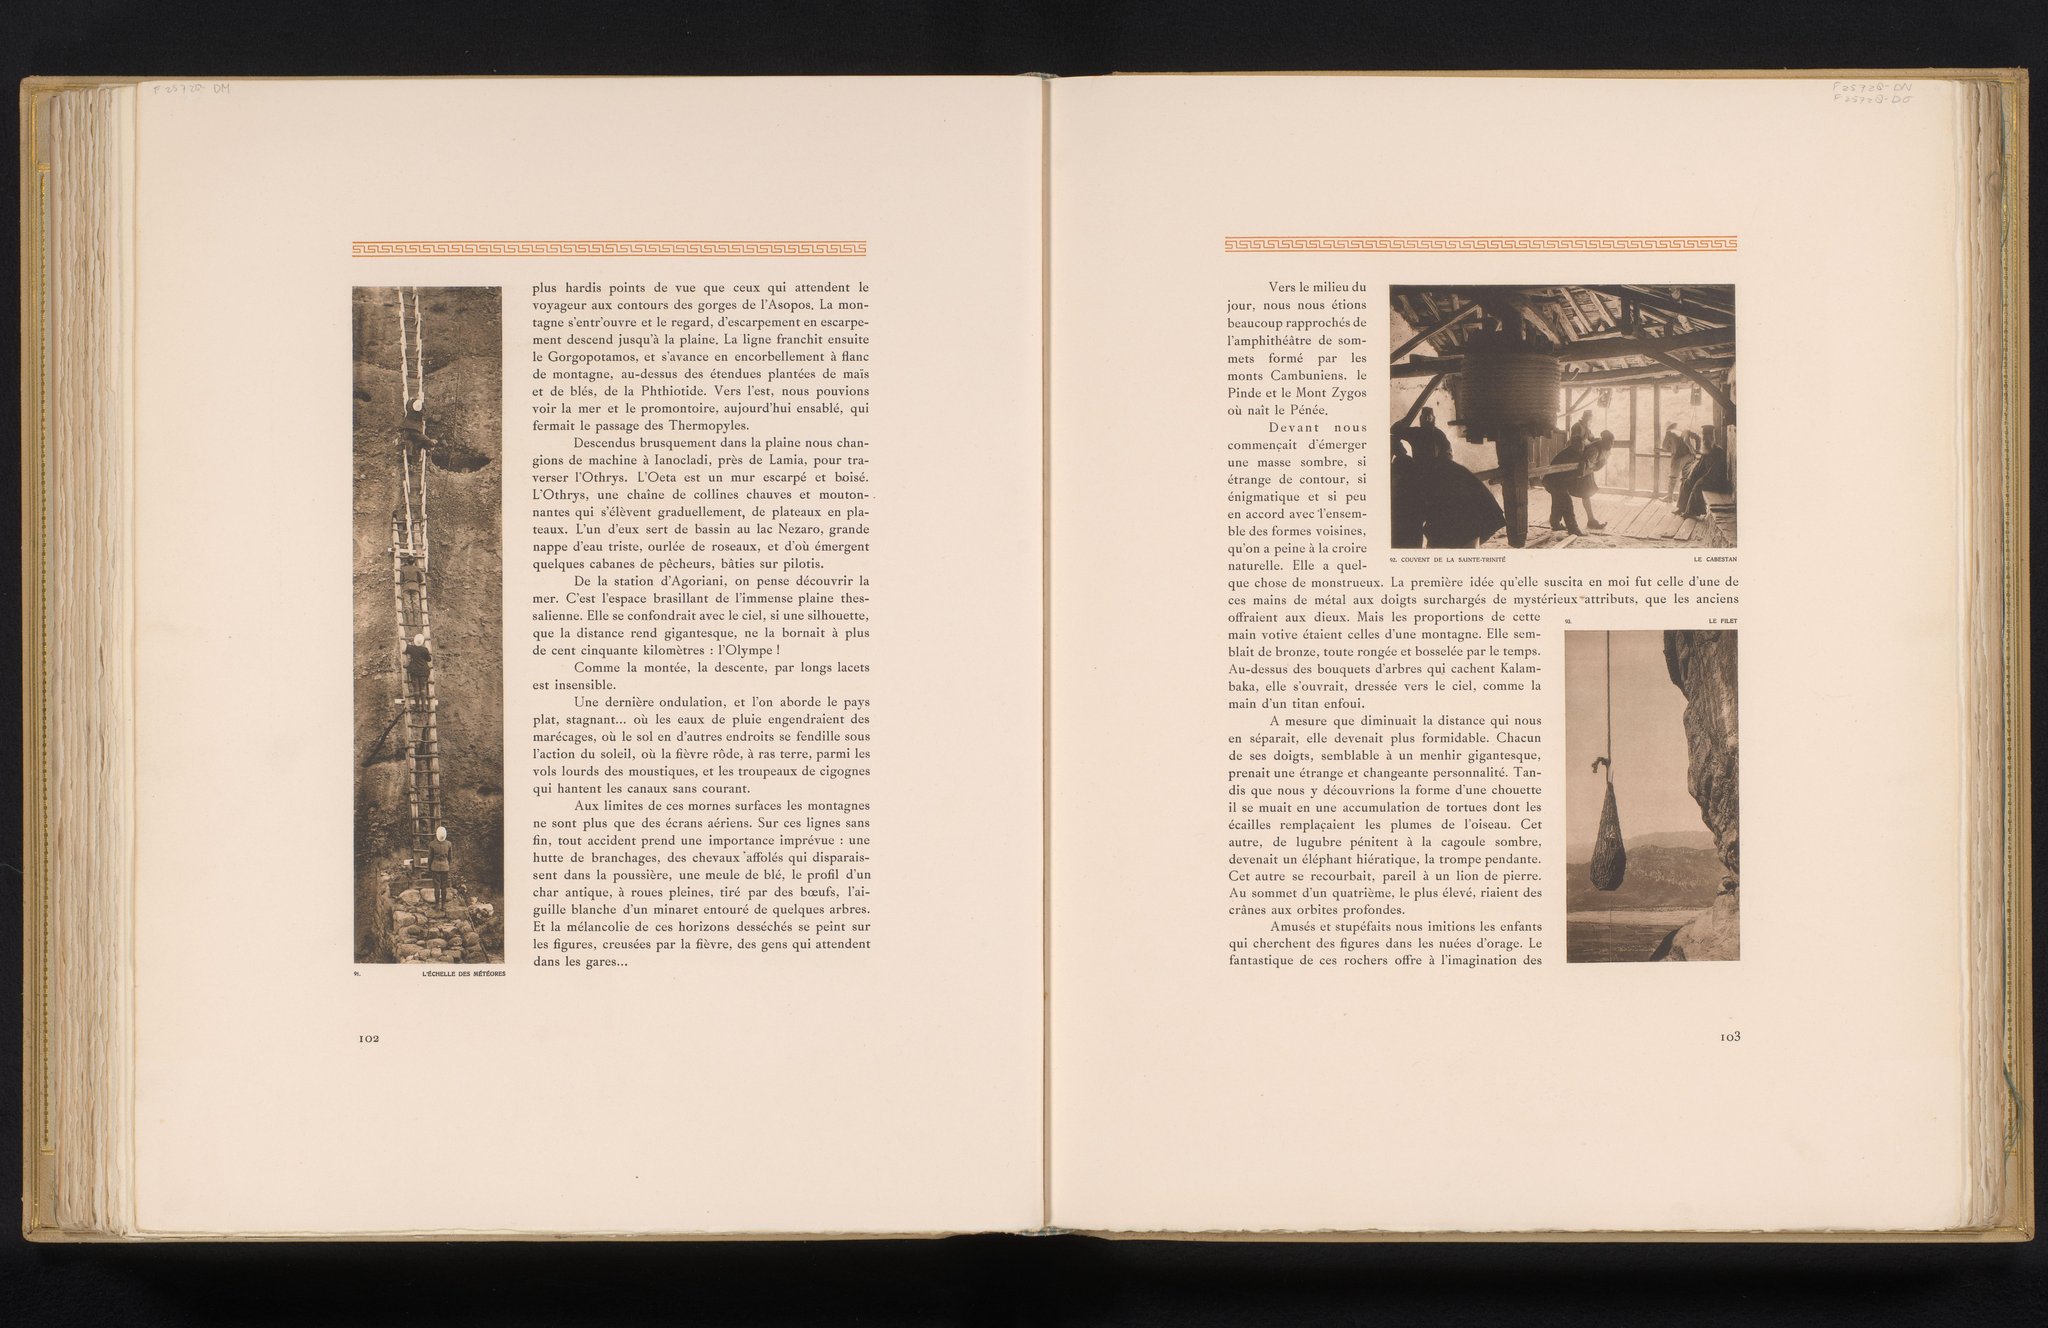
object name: page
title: Le filet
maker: frédéric boissonnas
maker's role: fotograaf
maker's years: 1858-1946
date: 1905-1910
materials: paper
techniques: photograph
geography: berlin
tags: container of textile material: bag, sack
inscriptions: number: ‘93.’